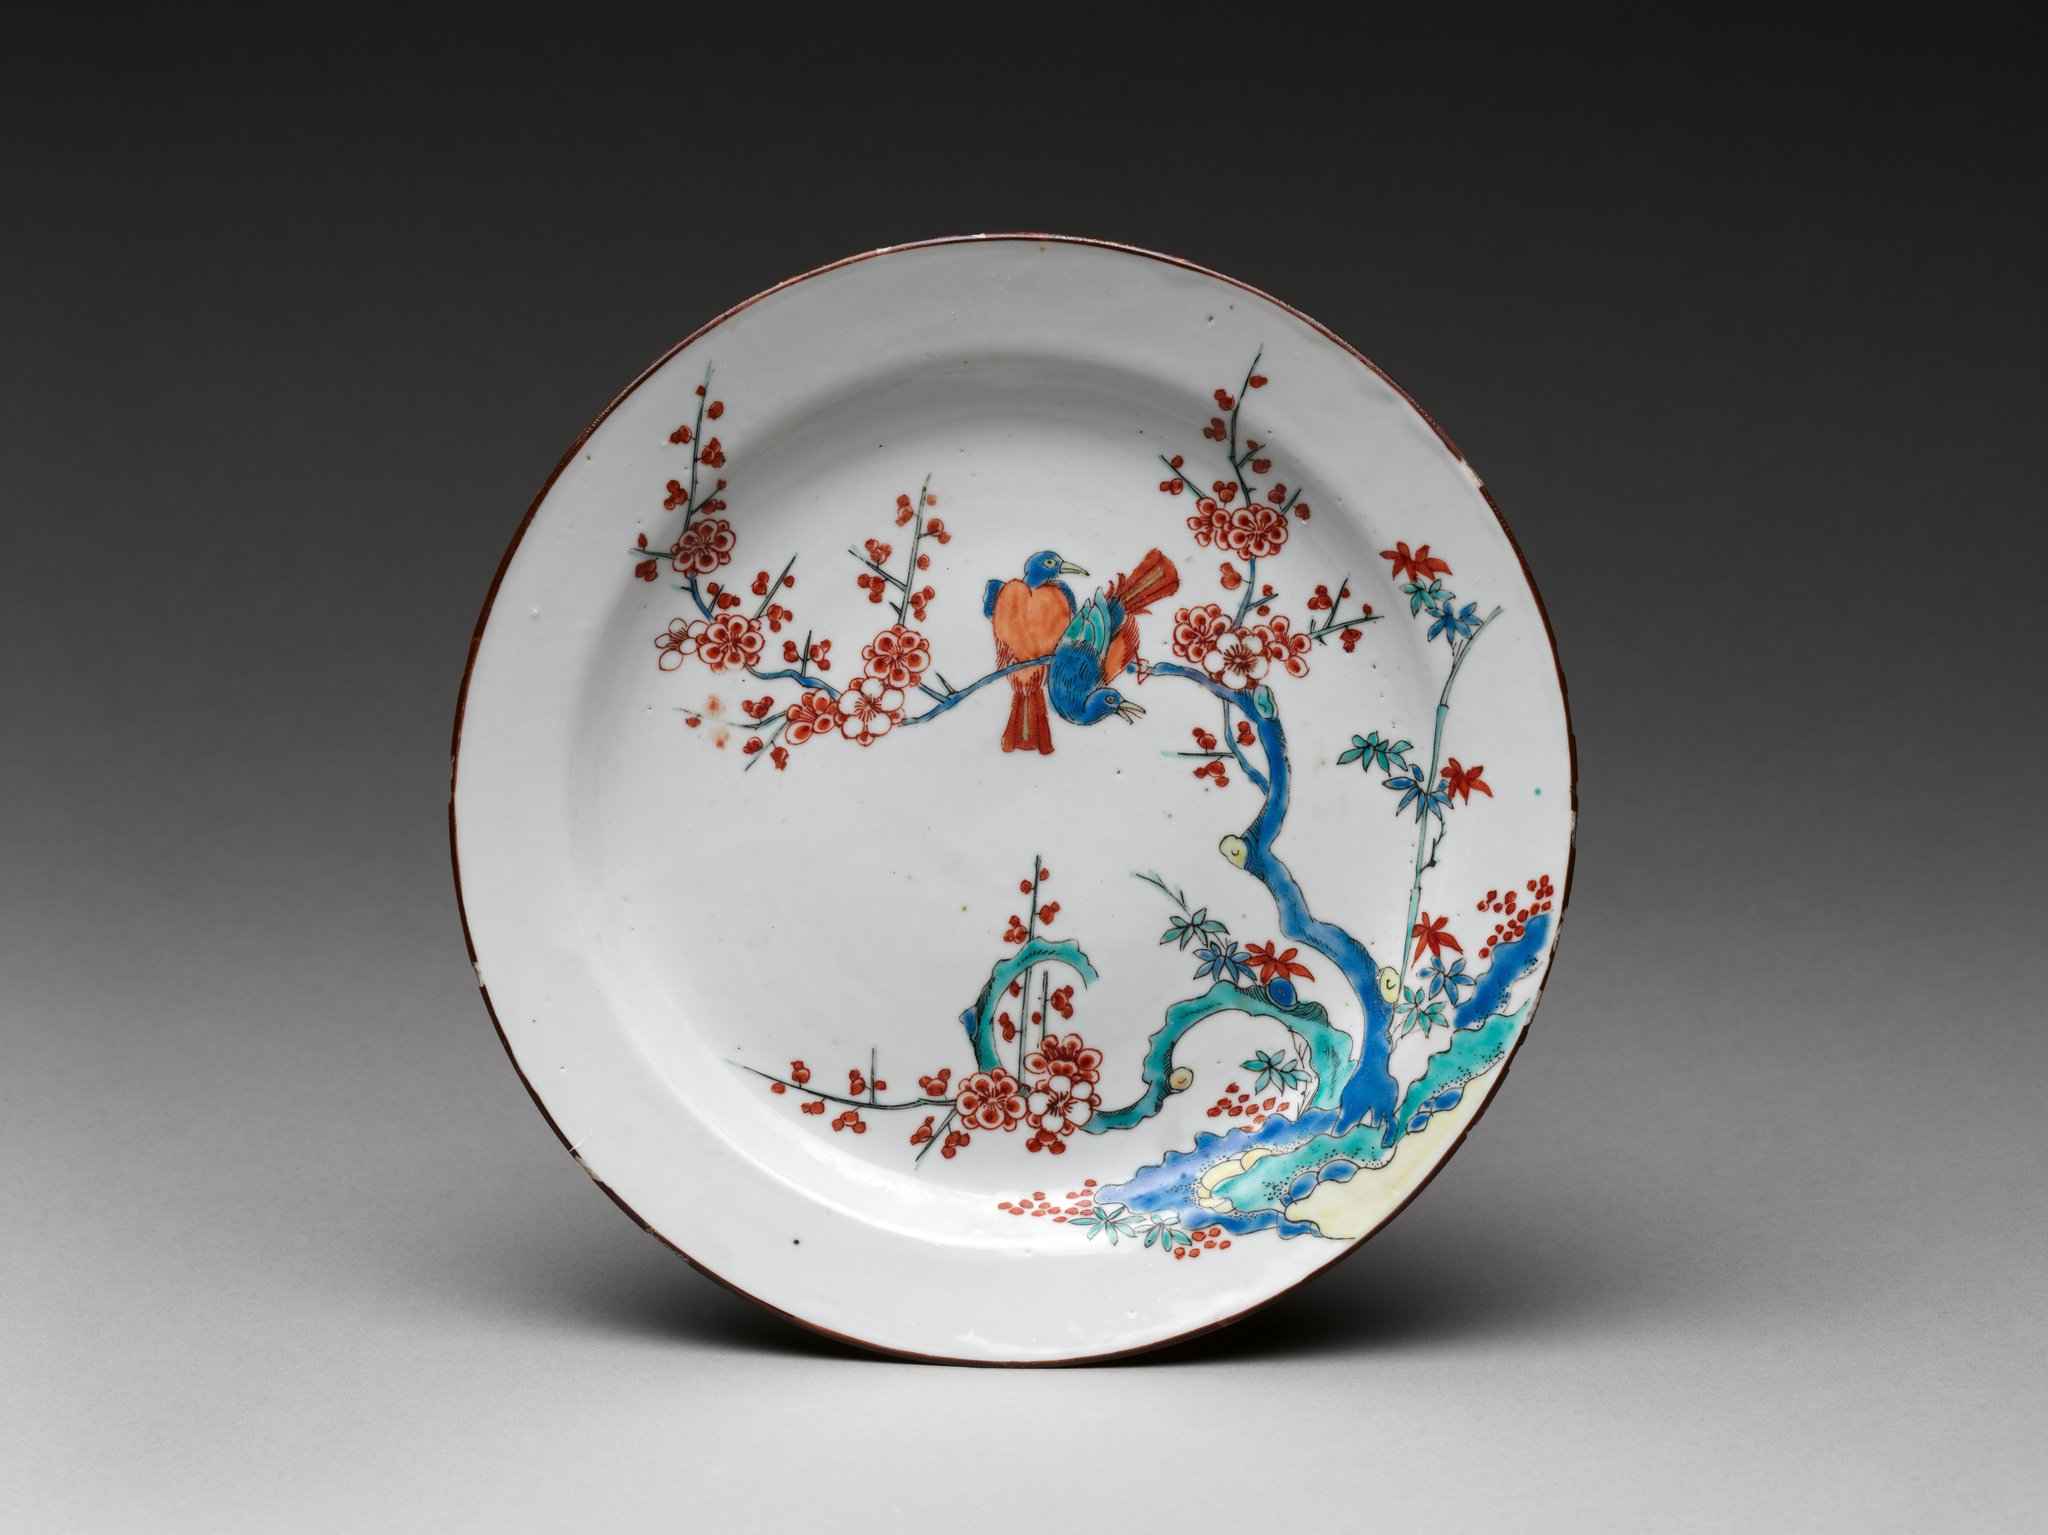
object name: dish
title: Dish with flowers and birds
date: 1701-1800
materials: hard paste porcelain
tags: birds,flowers